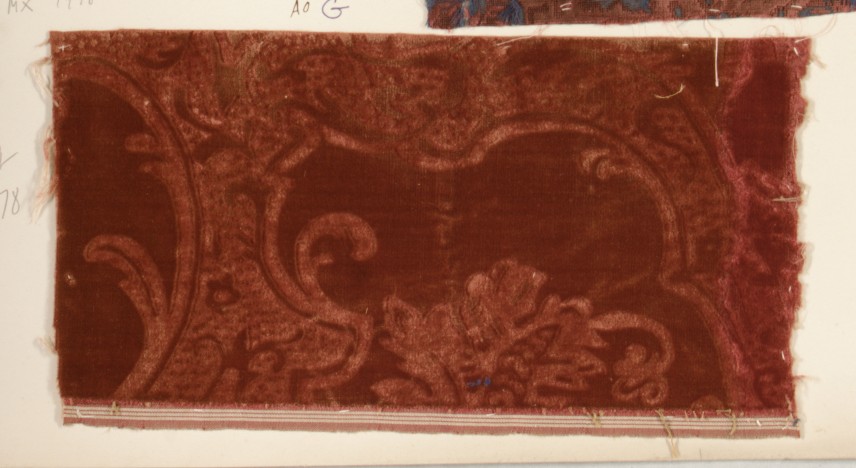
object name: fragment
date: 1501-1600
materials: silk